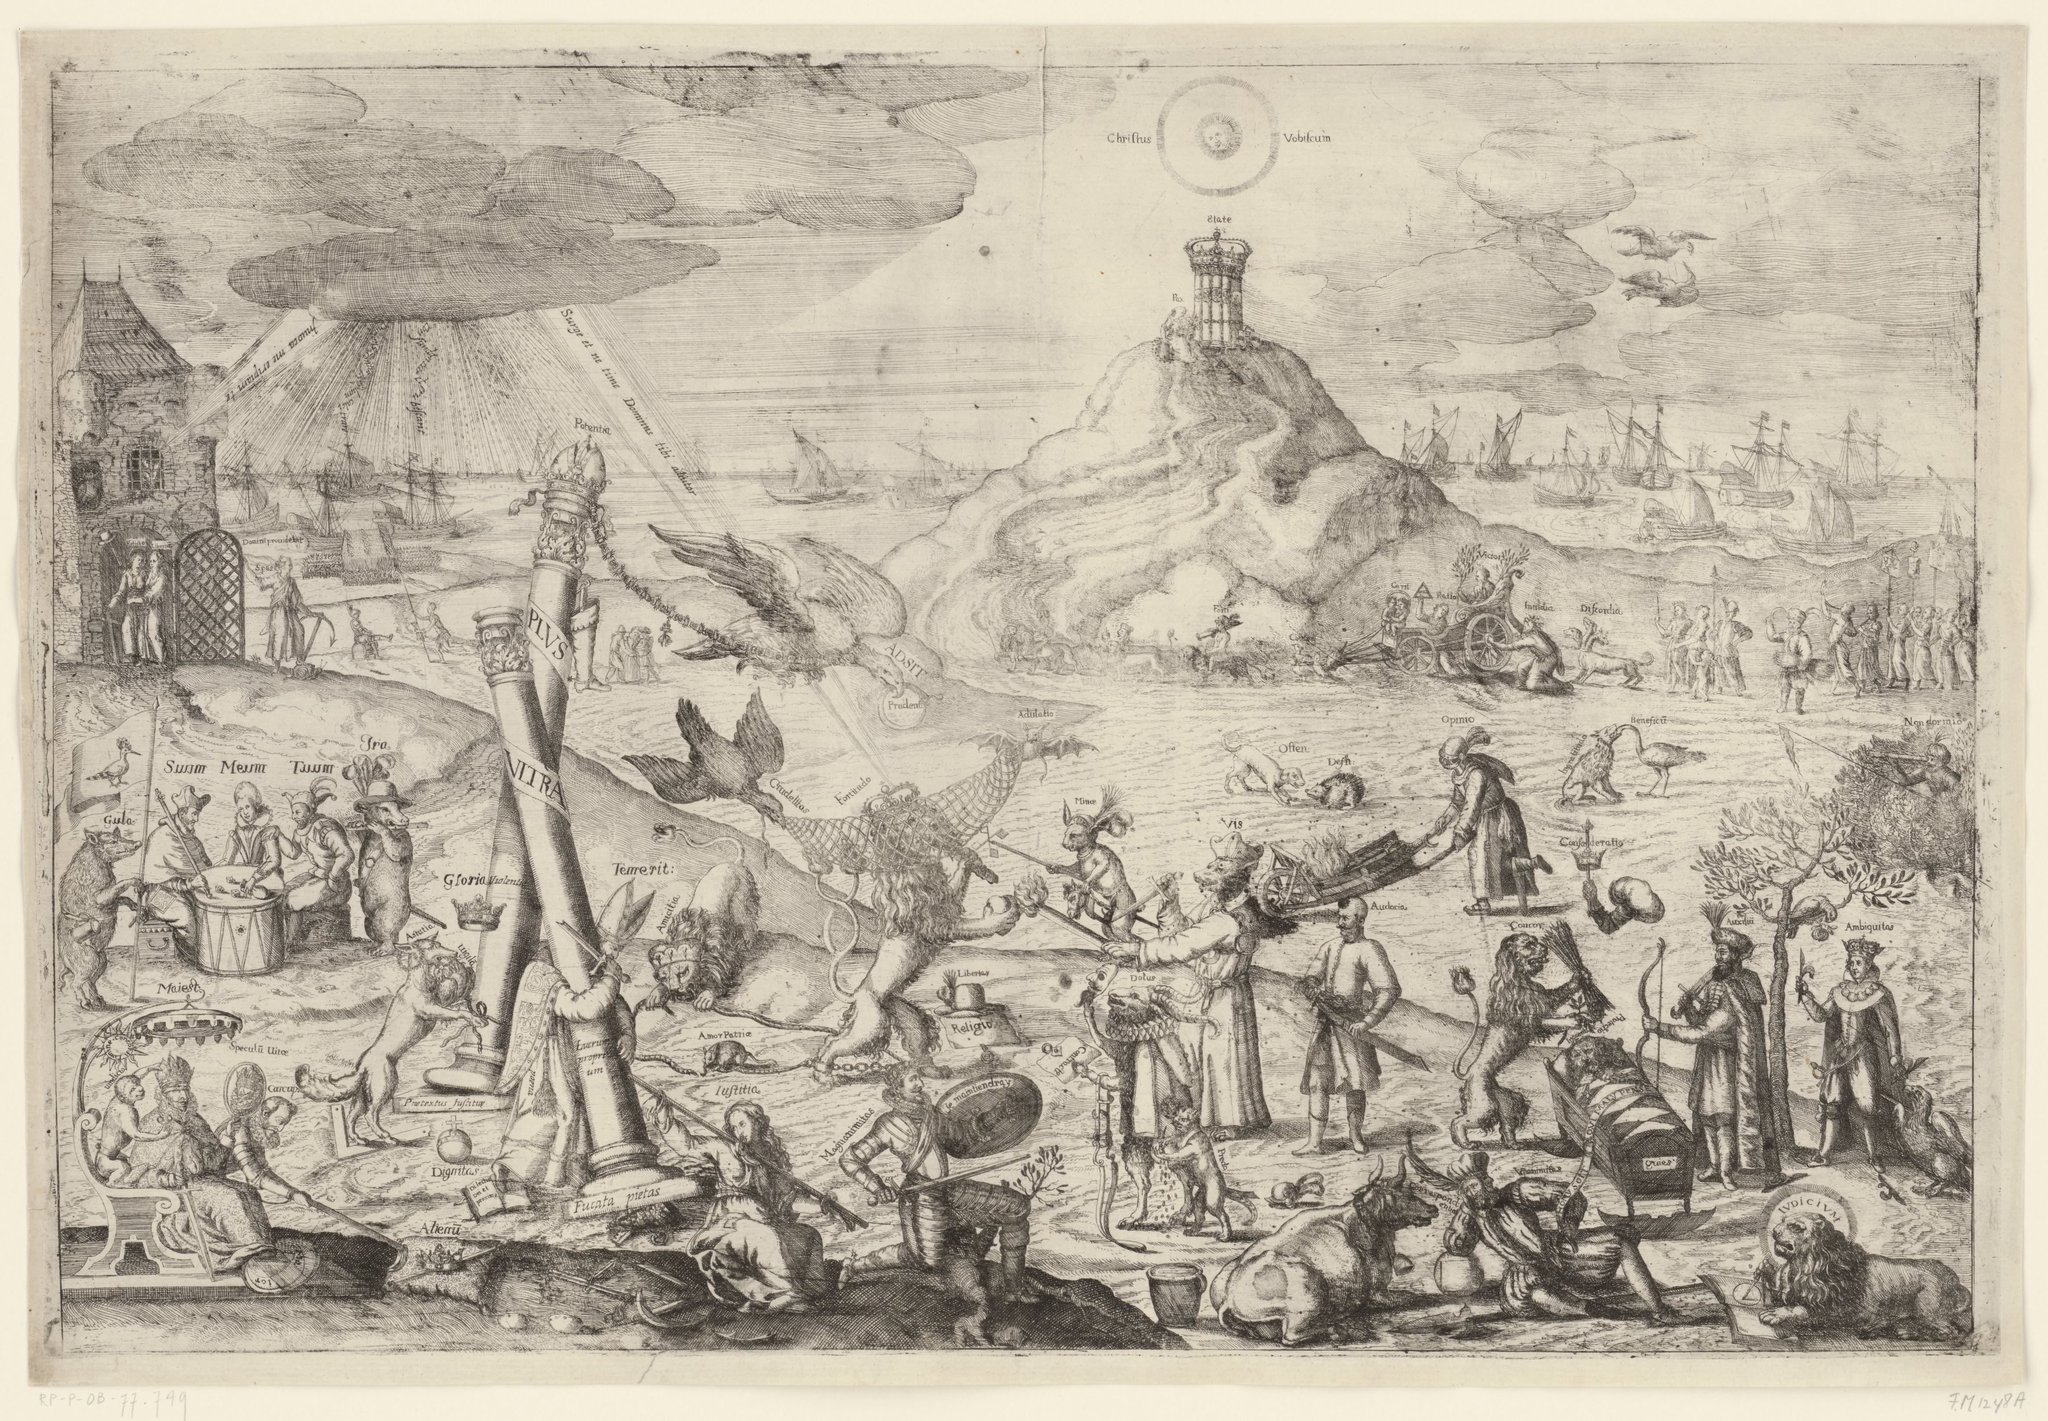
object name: propagandaprent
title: Allegorie op de politieke situatie in de Nederlanden in het jaar 1607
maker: Anonymous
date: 1607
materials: paper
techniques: engraving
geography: northern netherlands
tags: the hague, maurice (prince of orange)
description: Uitgebreide en gedetailleerde allegorie op de politieke situatie in de Nederlanden rond in het jaar 1607. Maurits in wapenrusting knielend bij de oranjeboom. Een duivel (Dolus) met masker reikt hem de voorstellen voor de vrede. Hiernaast een wolf in monnikspij (Vis) met dolk en fakkel. Naast Maurits de geketende Justitia. In het midden krijgt de Nederlandse Leeuw een net over de kop geworpen door een roofvogel (Crudelitas) en een vleermuis (Adulatio). Links duwen een bisschop (Temerit) en een vos (Astutia) tegen de zuilen van Karel V Plus Ultra. Op de achtergrond een triomfoptocht van Victoria in haar strijdwagen. Met vele andere details, dieren, emblemen en personifcaties. Alles met opschriften in het Latijn.